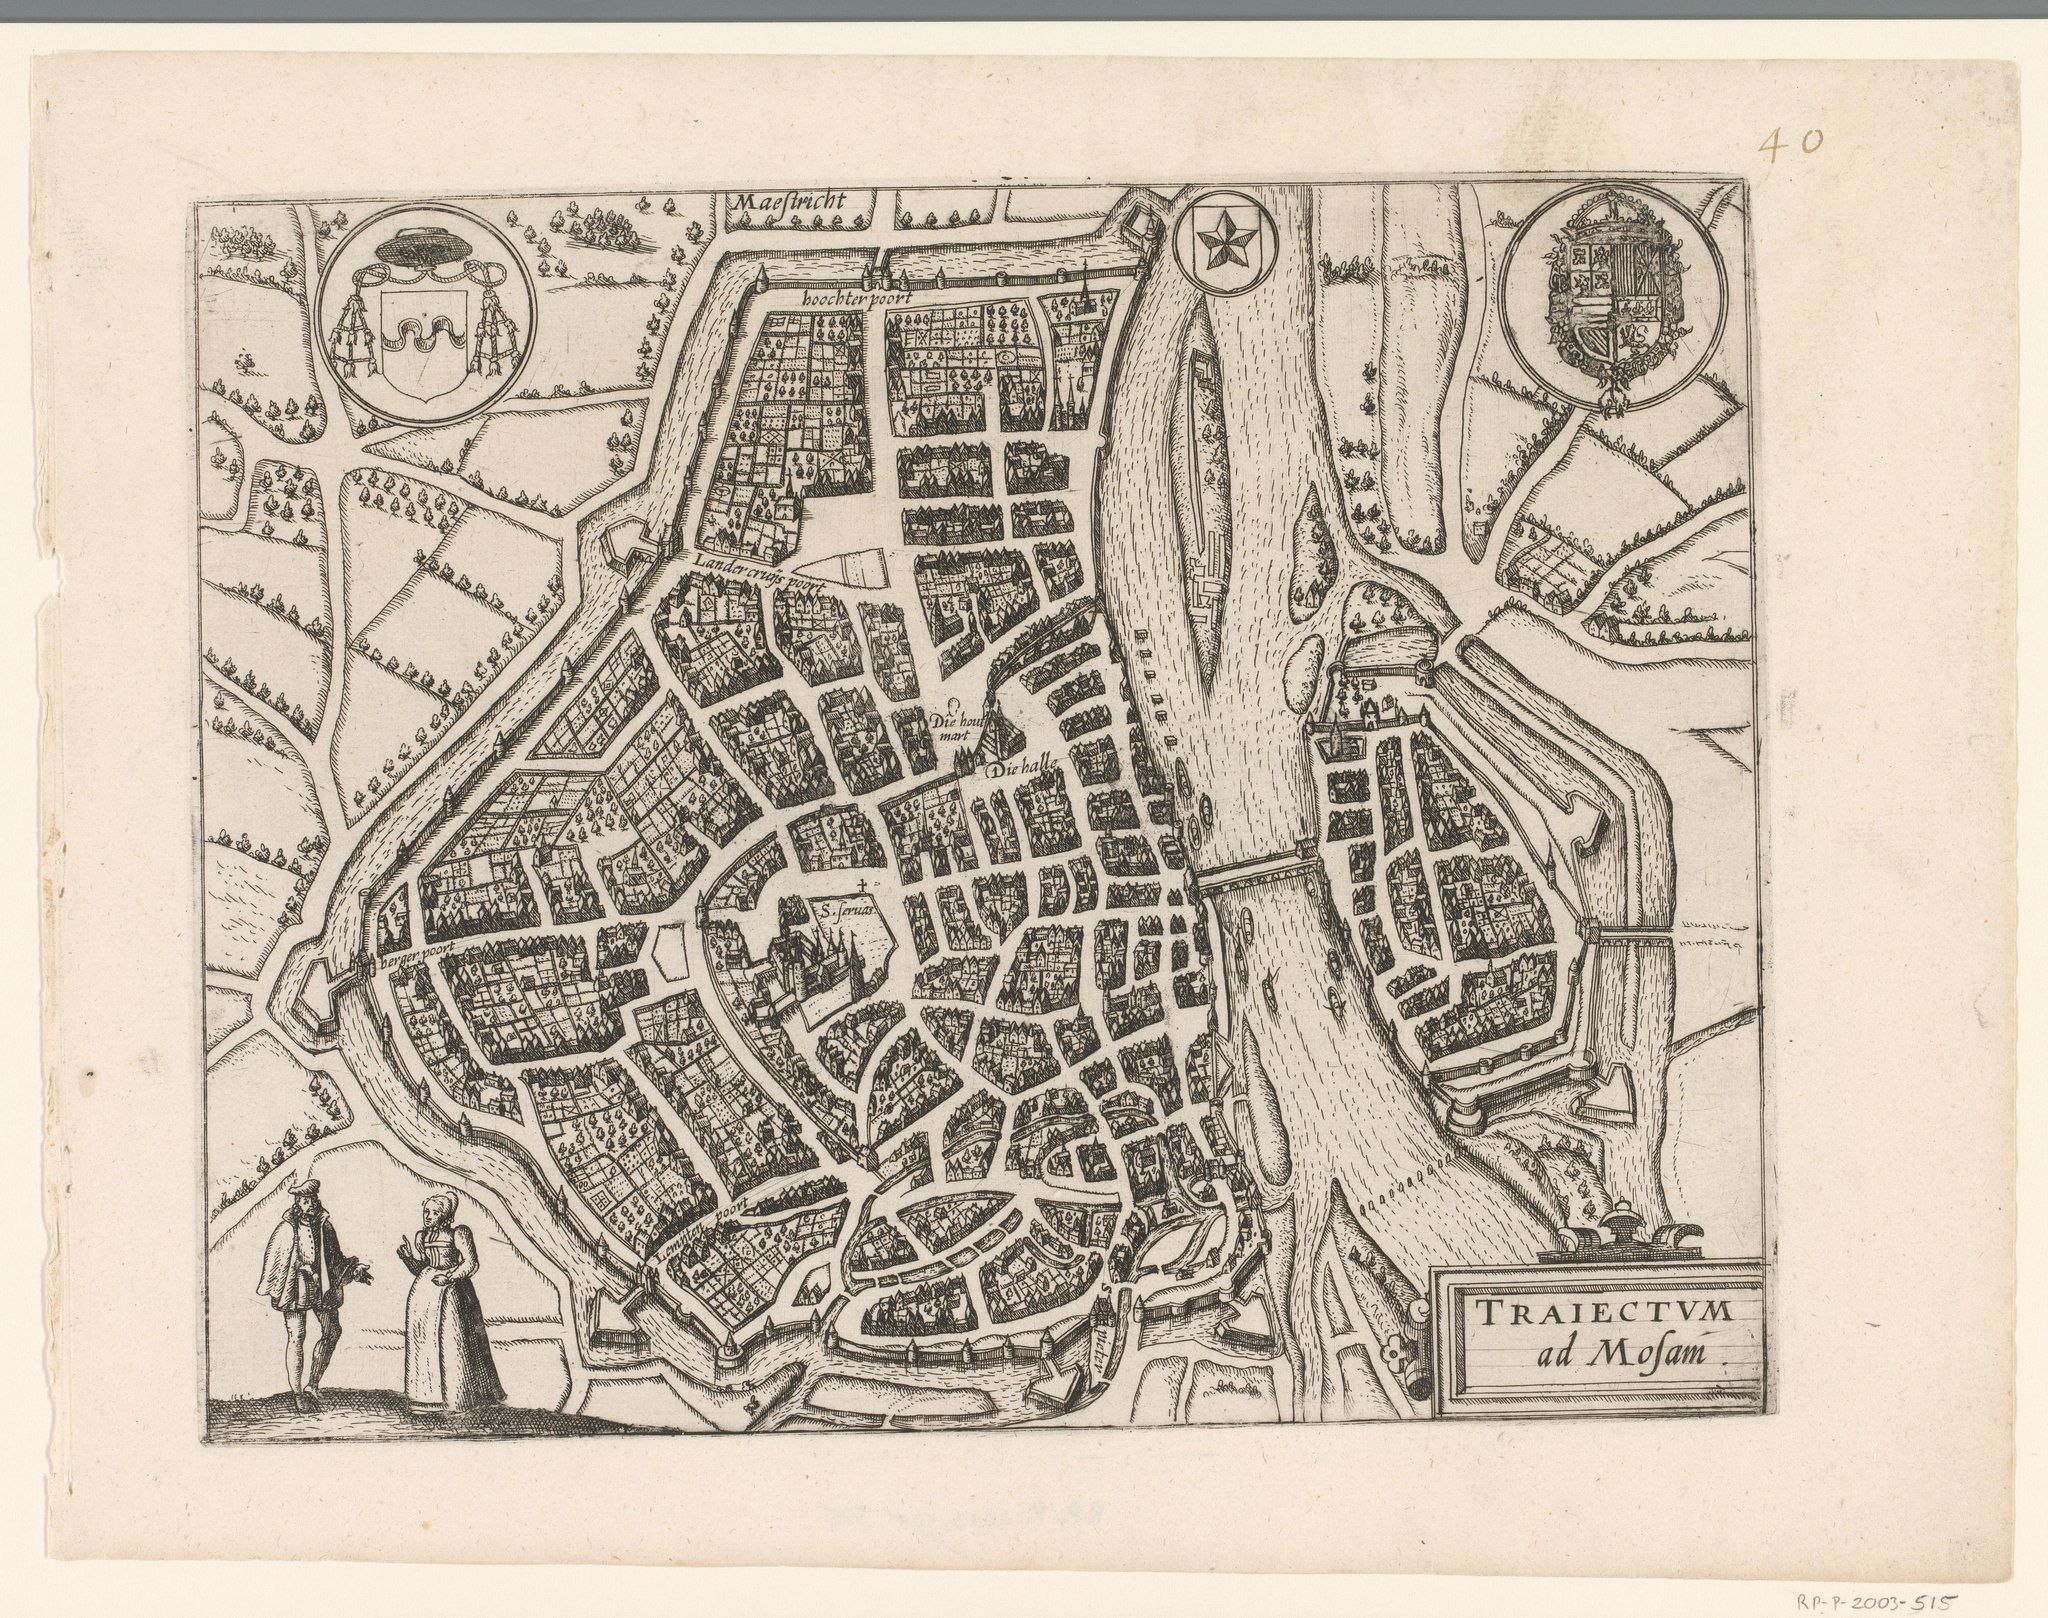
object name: area plan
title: Maestricht / Traiectum | ad Mosam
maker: Anonymous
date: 1607-1609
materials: paper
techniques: etching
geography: southern netherlands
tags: maps of cities, maastricht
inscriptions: number: ‘40’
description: Plattegrond van de stad Maastricht. Midden boven de titel, linksboven het wapen van de prinsbisdom Luik, rechtsboven het stadswapen en de wapen van de koning van Spanje. Rechtsonder een cartouche met de Latijnse titel. Linksonder een man en een vrouw. Onderdeel van de verzameling kaarten genomen uit een latere editie van: Descrittione di tutti i Paesi Bassi van Lodovico Guicciardini.